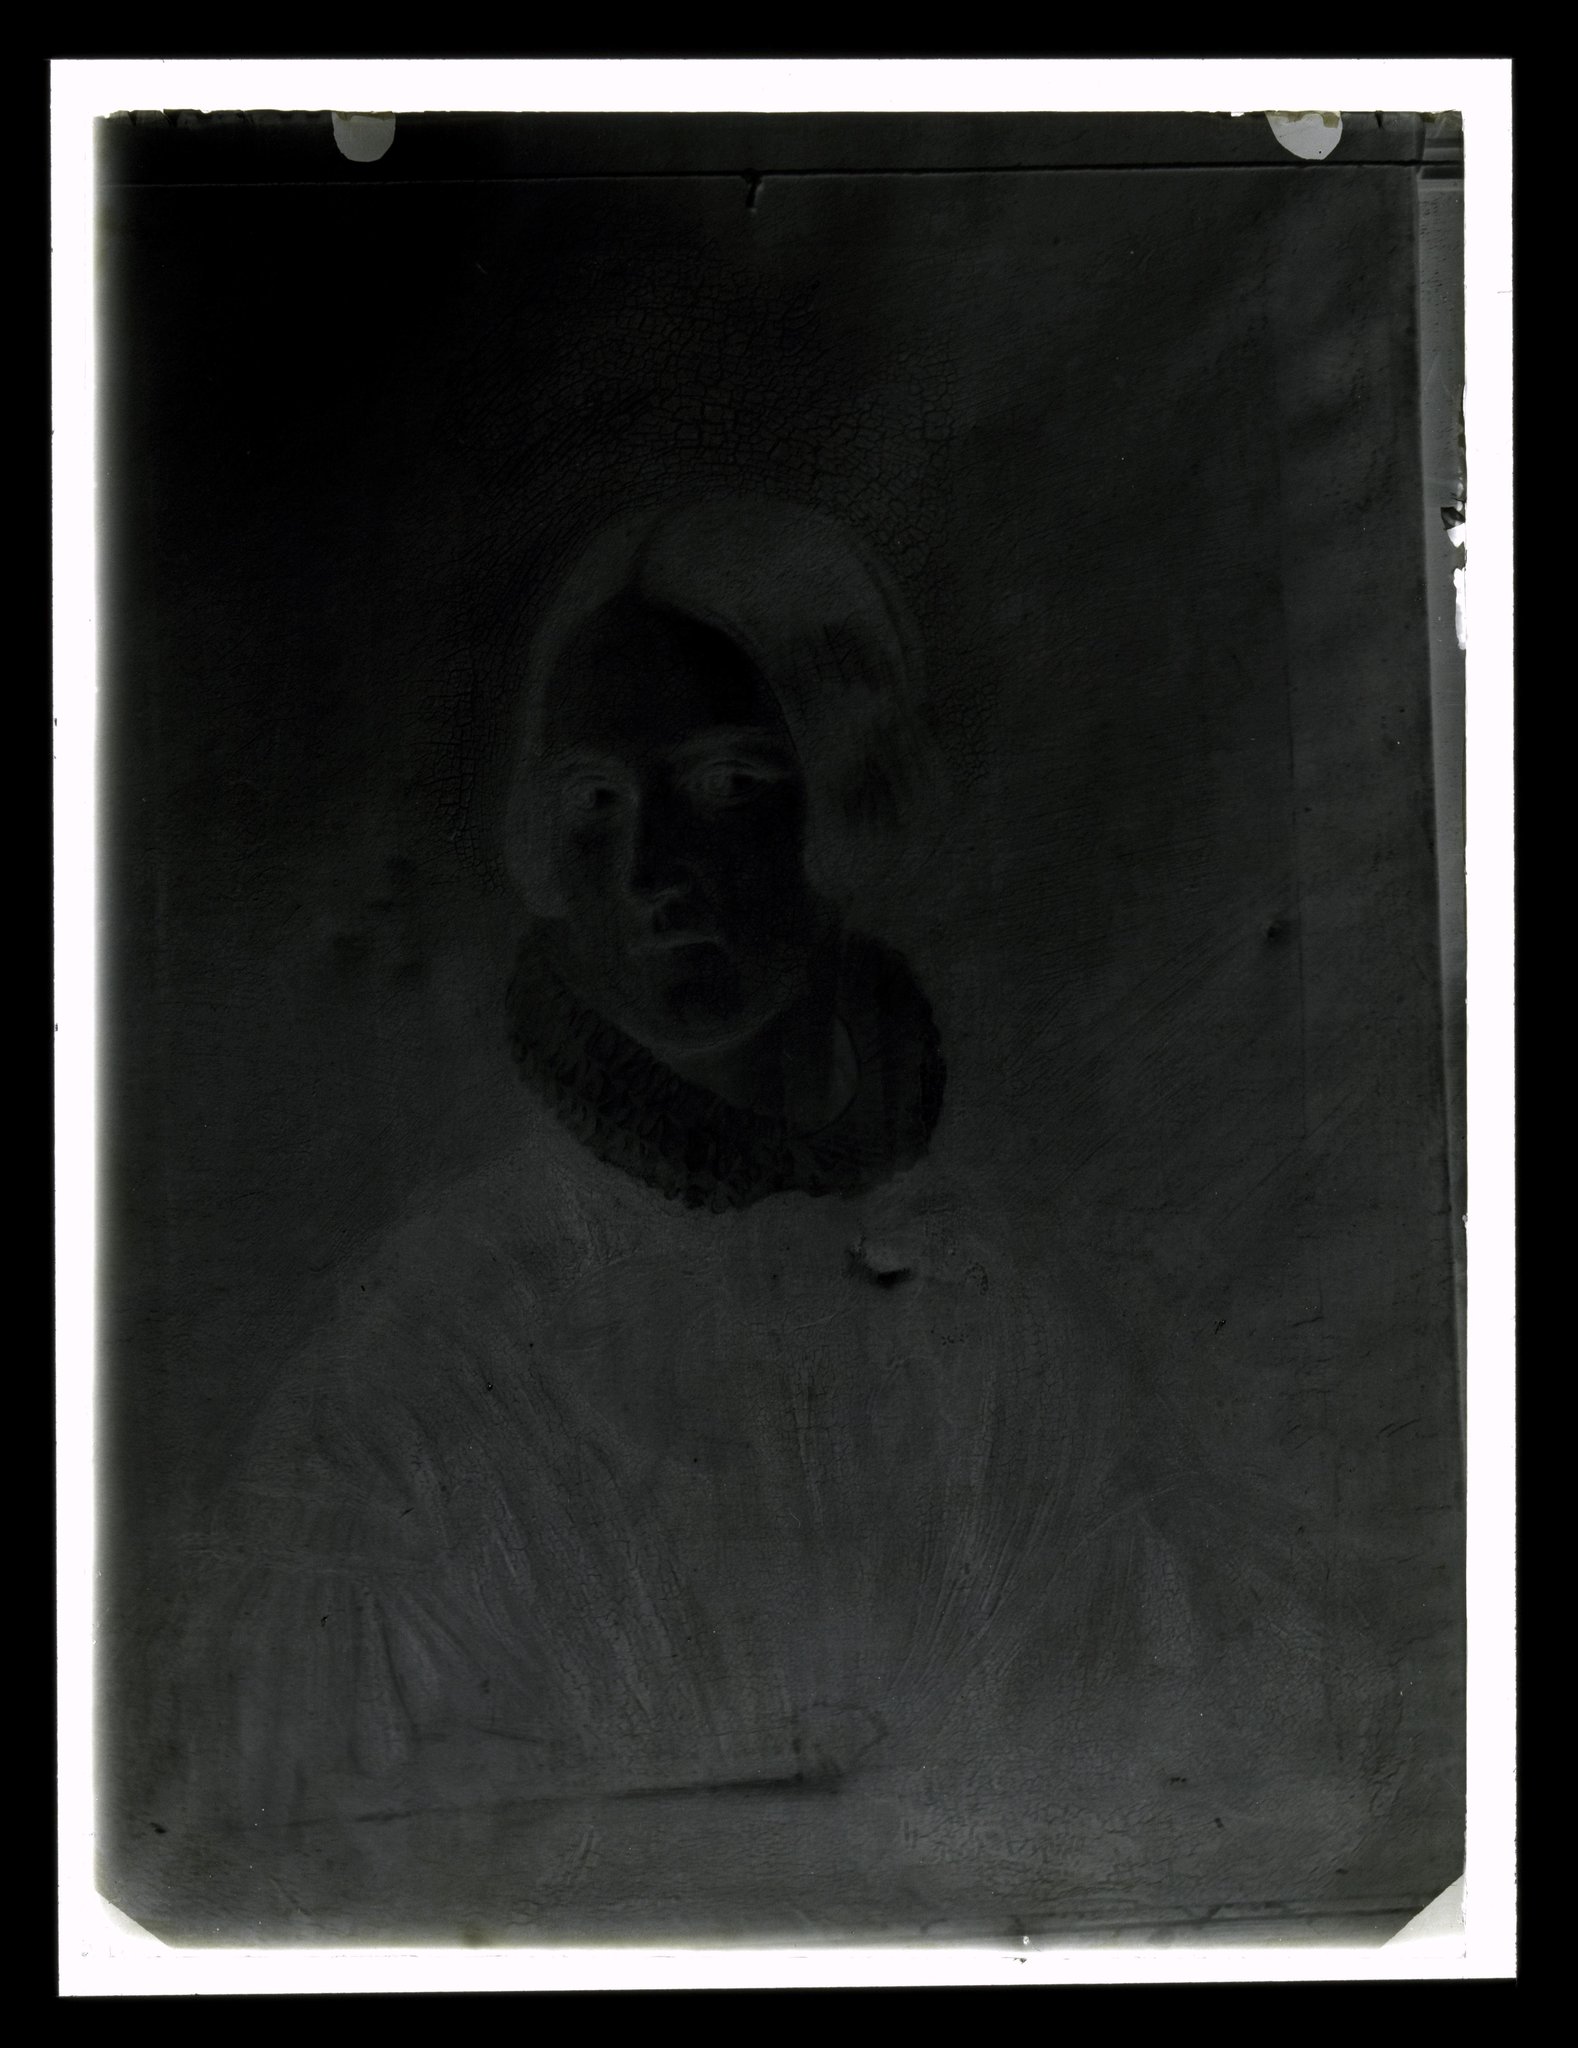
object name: reproduction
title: Fotoreproductie van een geschilderd portret van een onbekende vrouw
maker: laurens lodewijk kleijn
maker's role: draughtsman, painter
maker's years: 1826-1909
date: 1865-1900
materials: glass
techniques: collodion process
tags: historical persons - bb - woman, picture, painting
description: Onderdeel van groep glasnegatieven uit de nalatenschap van de schilder Laurens Lodewijk Kleijn, stillevens, portretten, zelfportretten en kunstreproducties.